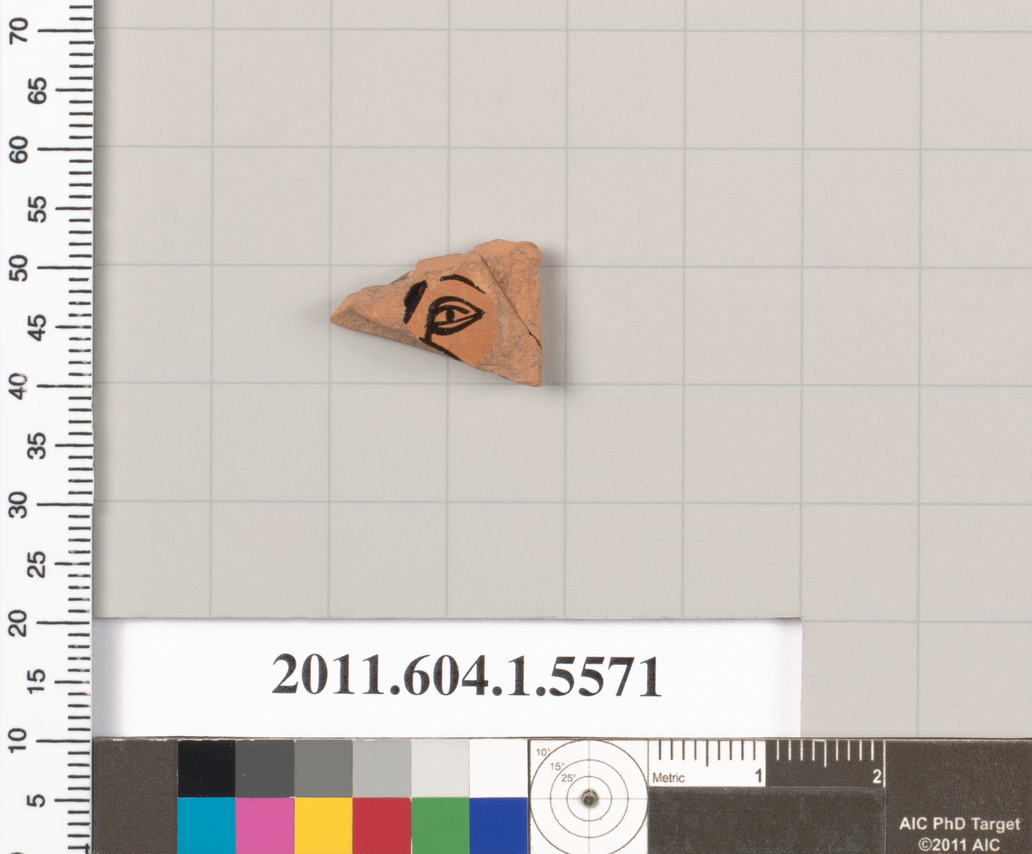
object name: kylix fragment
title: Terracotta fragment of a kylix (drinking cup)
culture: greek, attic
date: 520-510 BCE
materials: terracotta